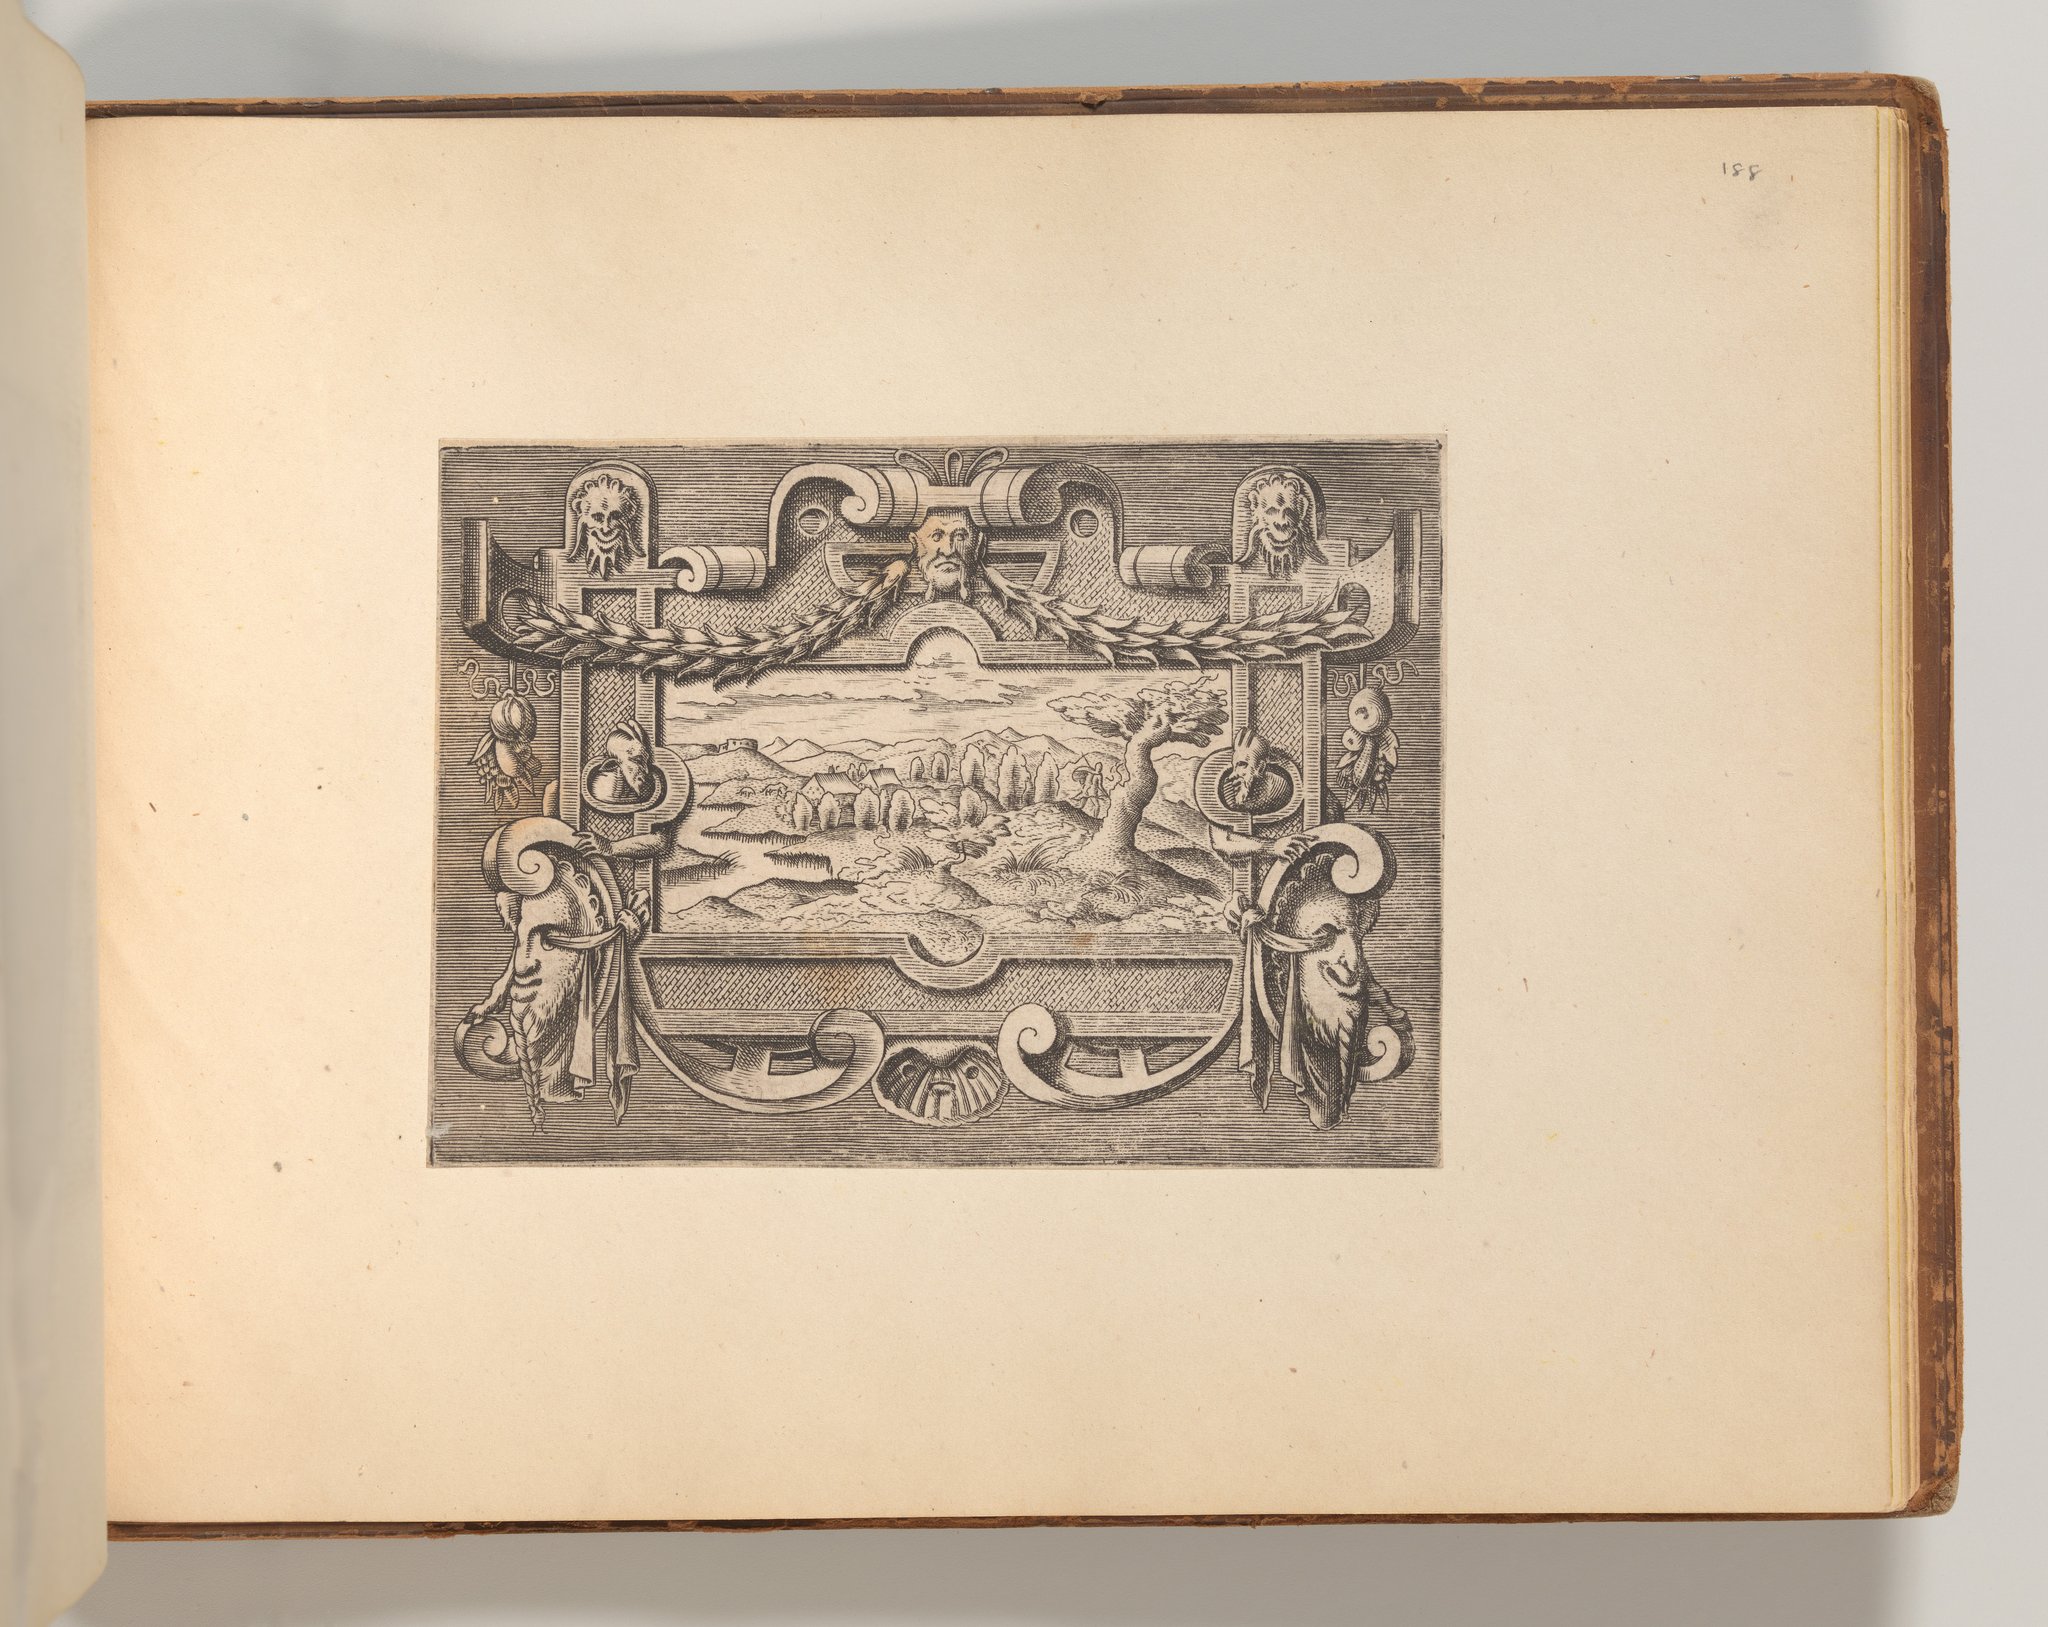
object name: album print ornament architecture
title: Series of Cartouches, in: Targhe ed altri ornati di varie e capricciose invenzioni (Cartouches and other ornaments of various and capricious invention, page 51)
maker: cornelis bos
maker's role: artist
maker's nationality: netherlandish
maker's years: 1510-1556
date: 1545-1560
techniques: engraving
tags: masks,cartouches,ornament,landscapes